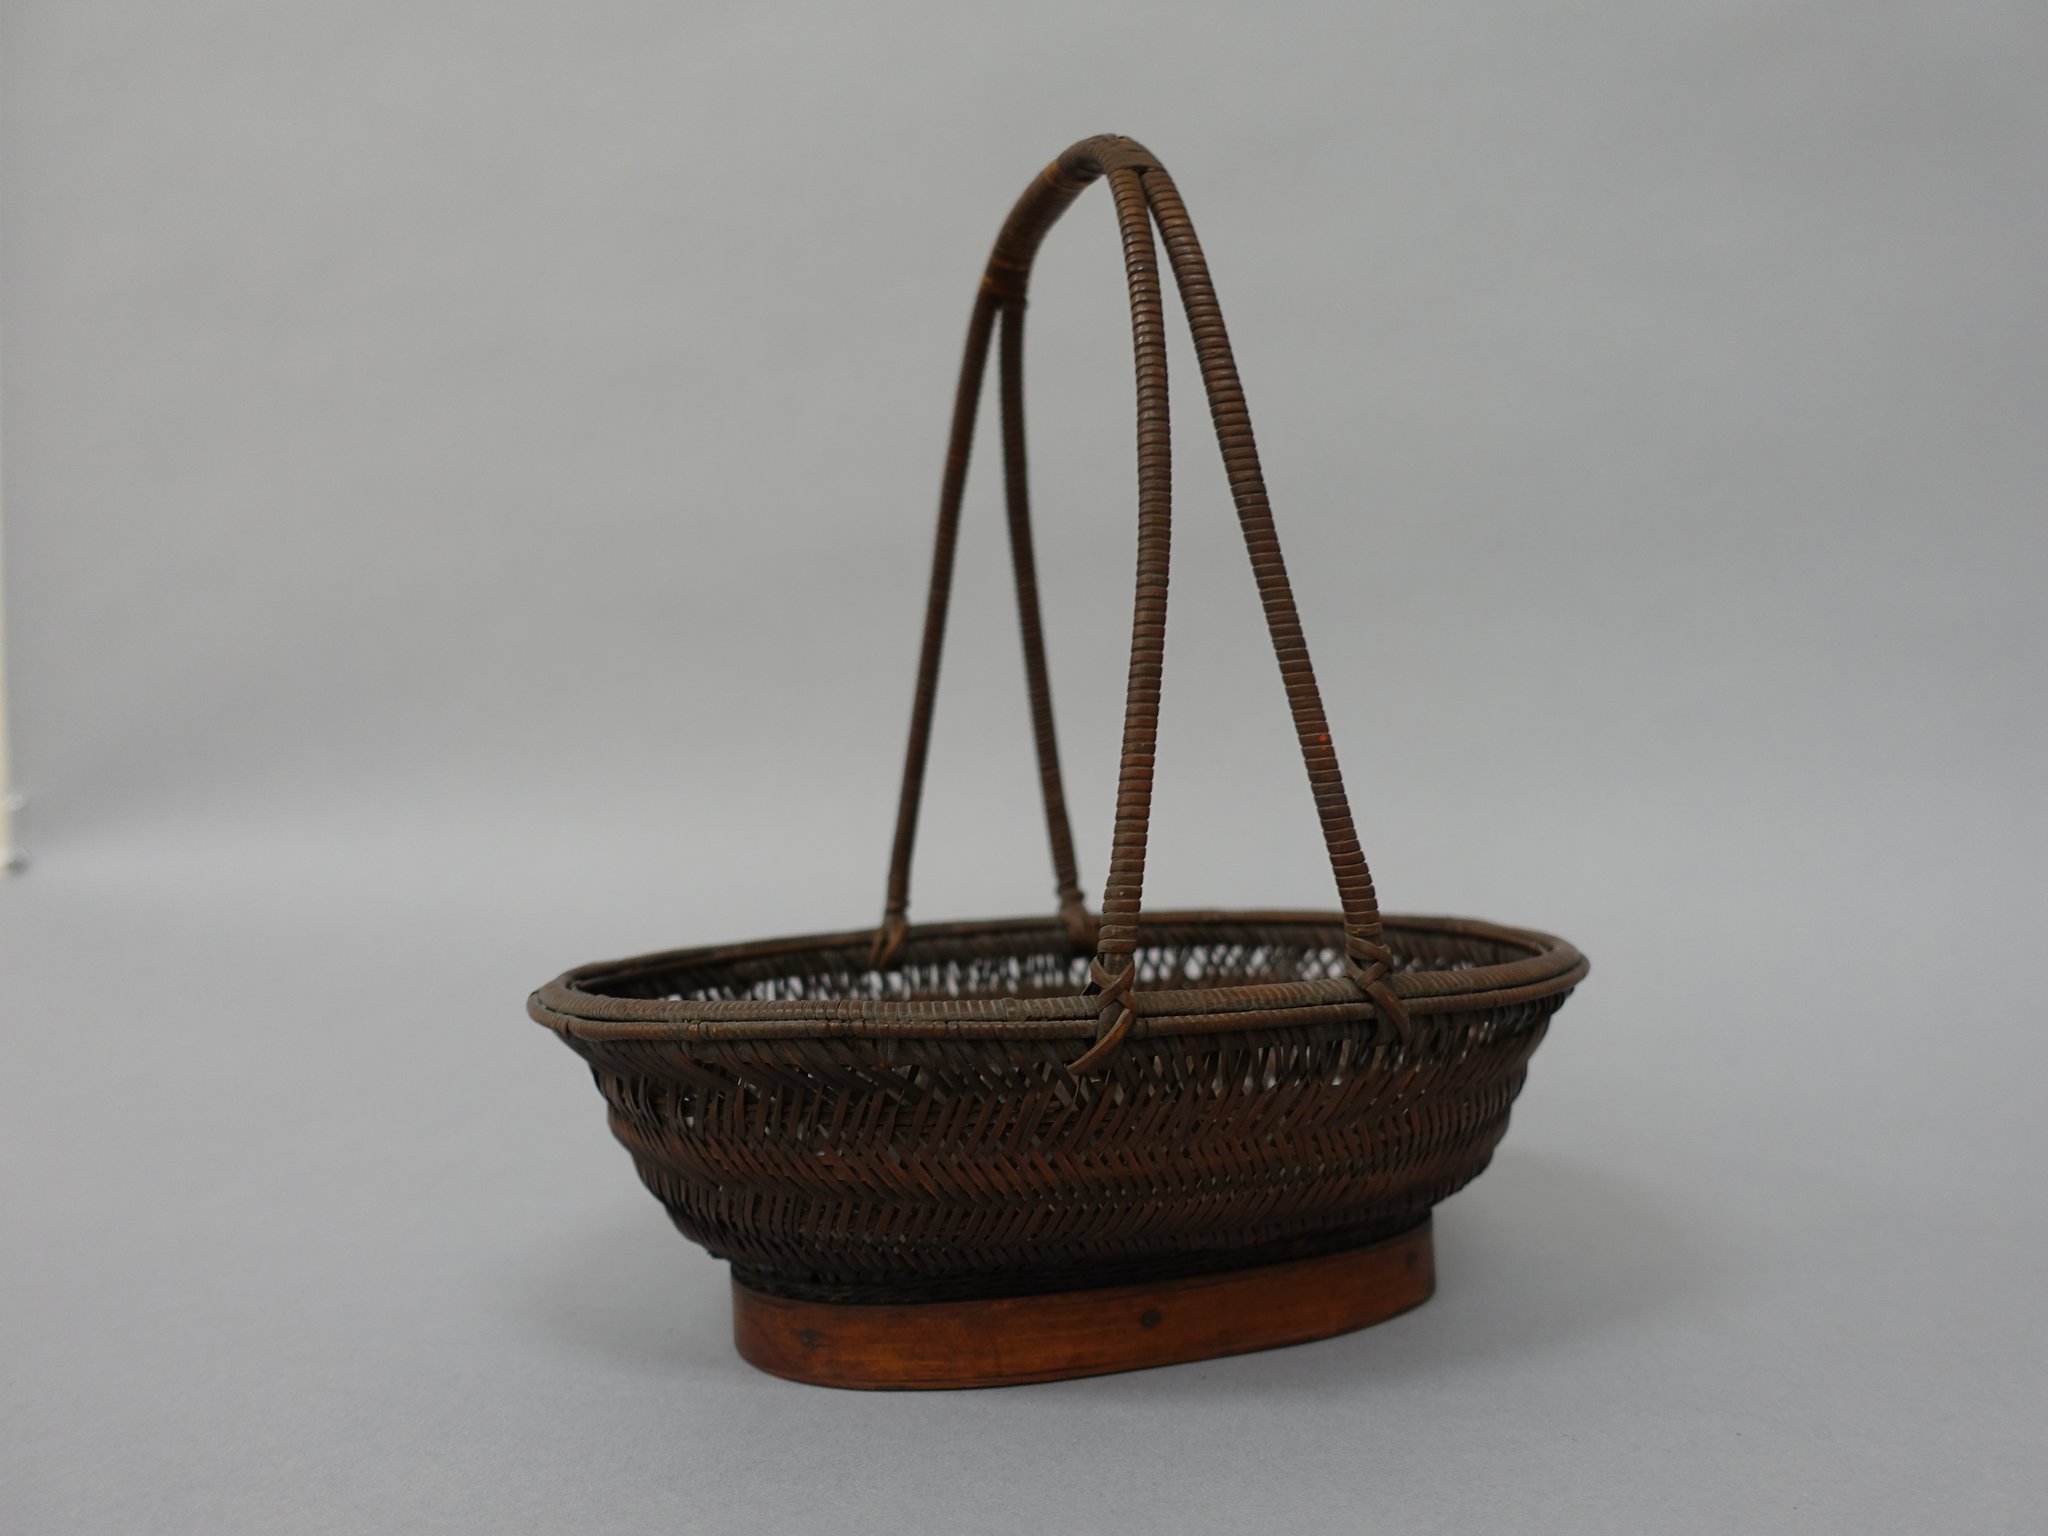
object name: basket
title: Boat-Shaped Fruit Basket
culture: china or japan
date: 1867-1900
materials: bamboo